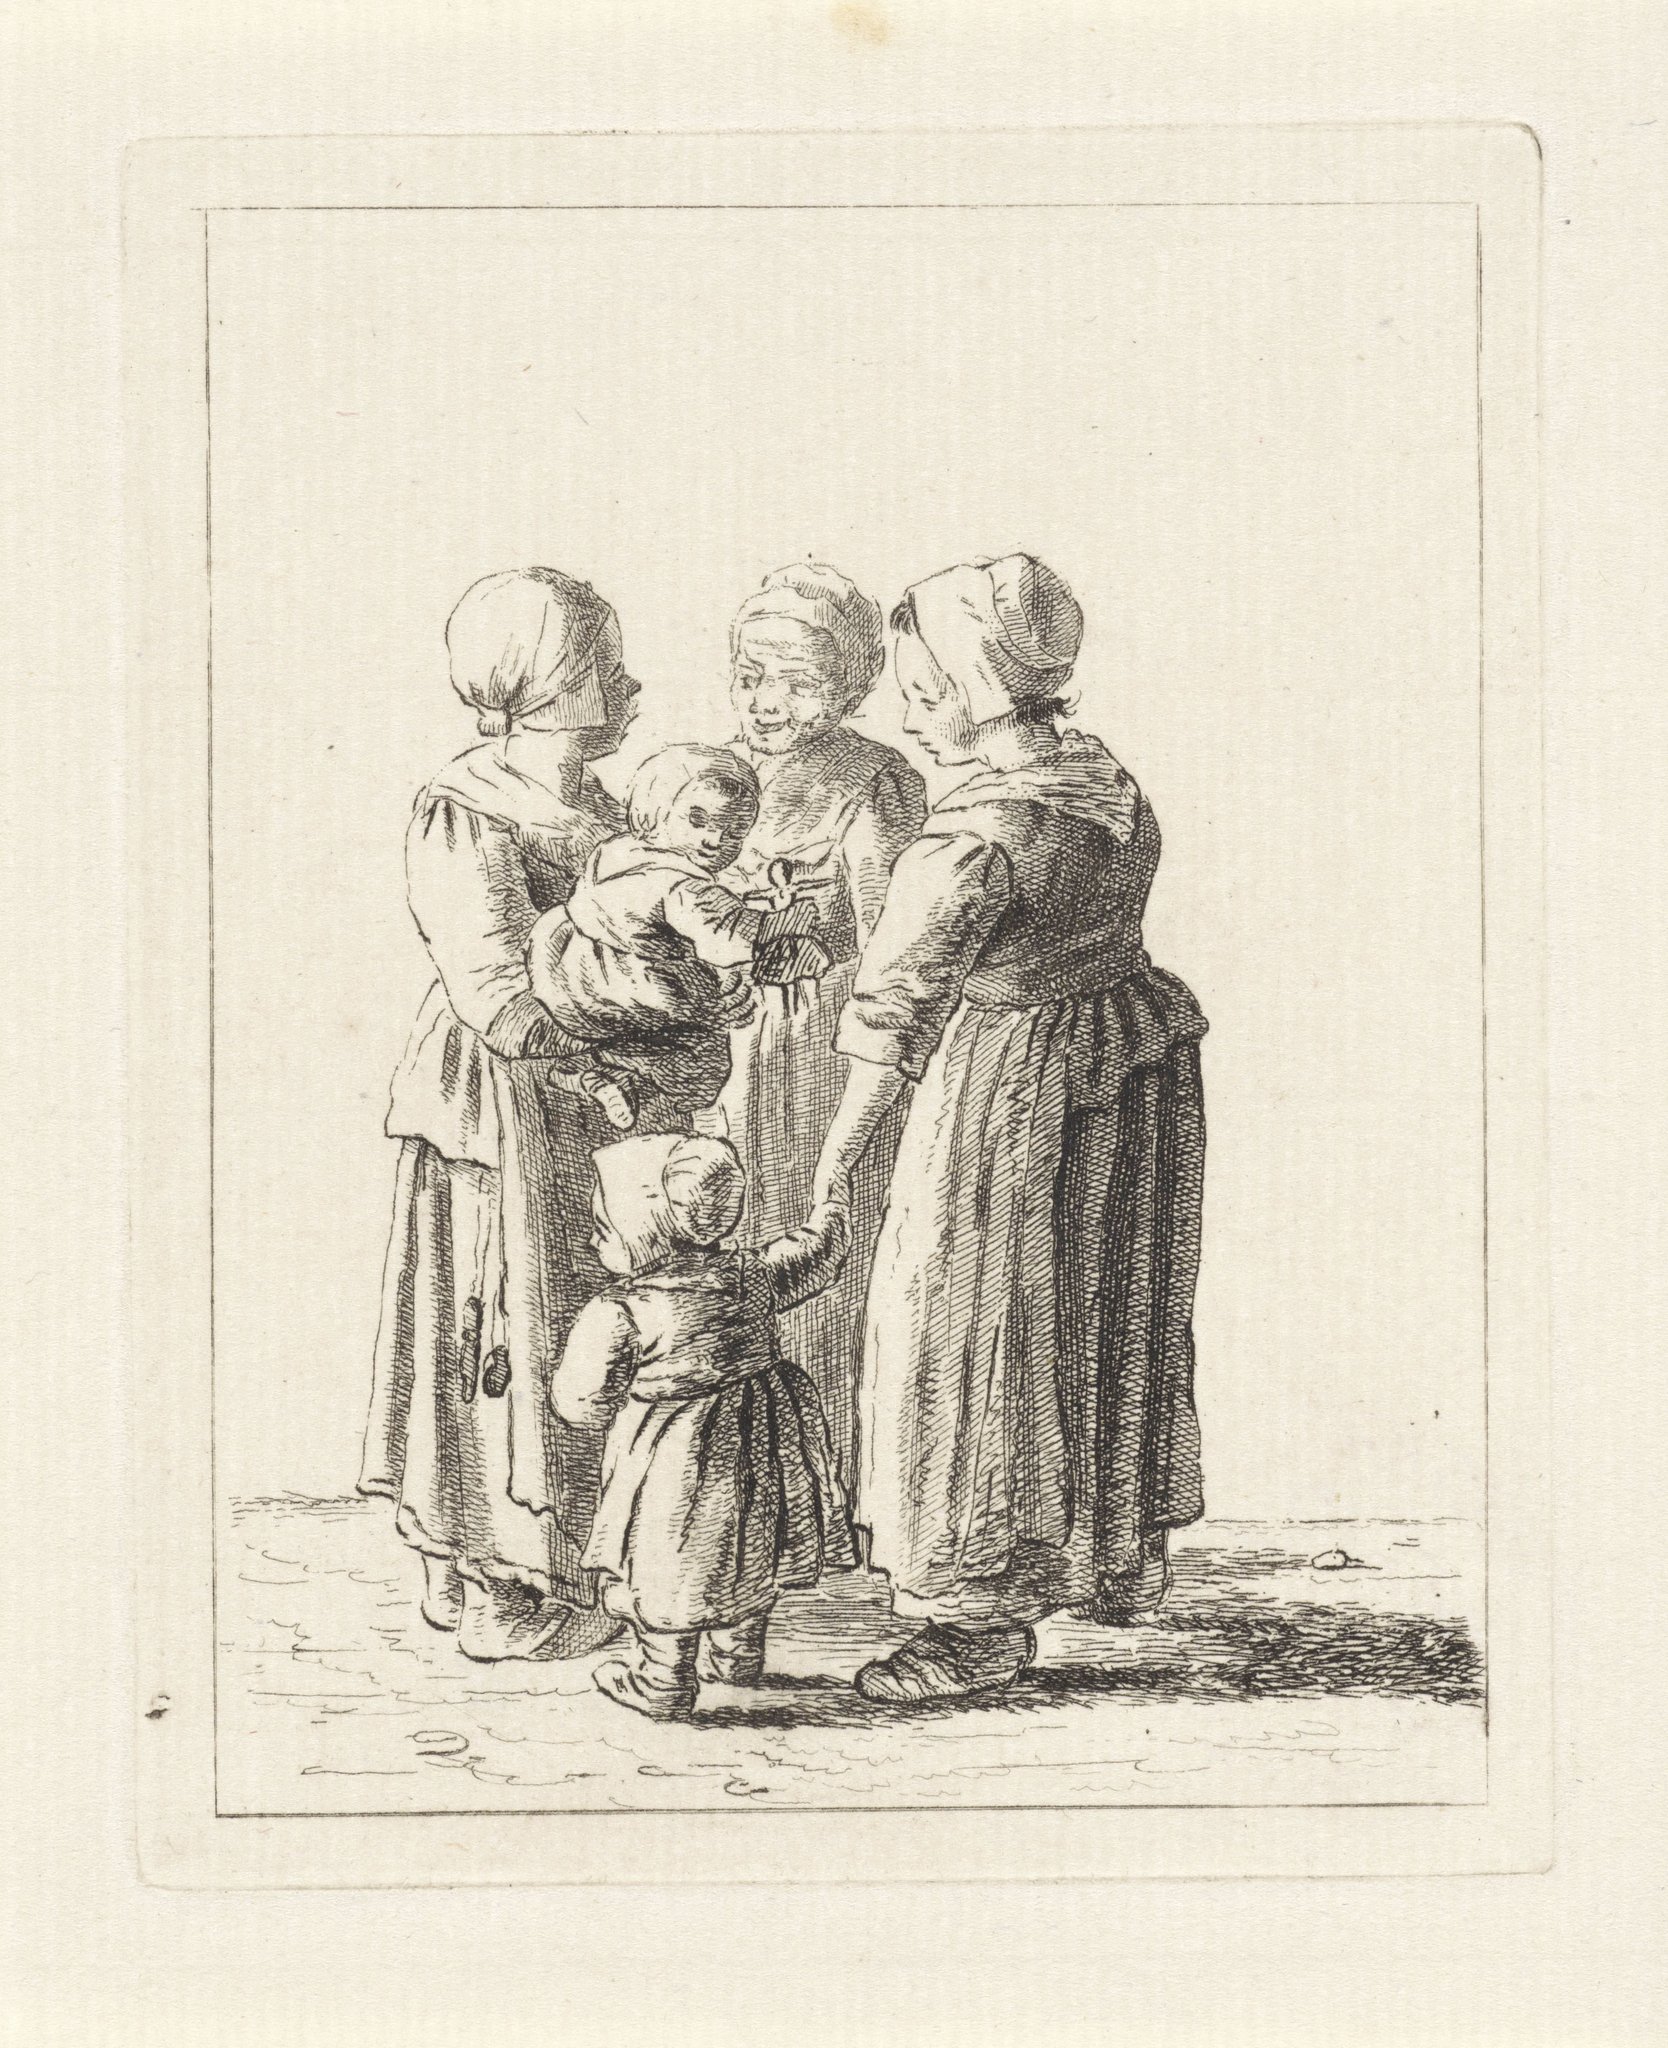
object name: print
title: Groep van drie vrouwen en twee kinderen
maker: nicolaas van der worm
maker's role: draughtsman, print maker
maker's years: 1757-1828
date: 1772-1828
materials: paper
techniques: etching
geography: leiden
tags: mother and child(ren), woman and child(ren) (family group)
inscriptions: collector's mark: Lugt 240